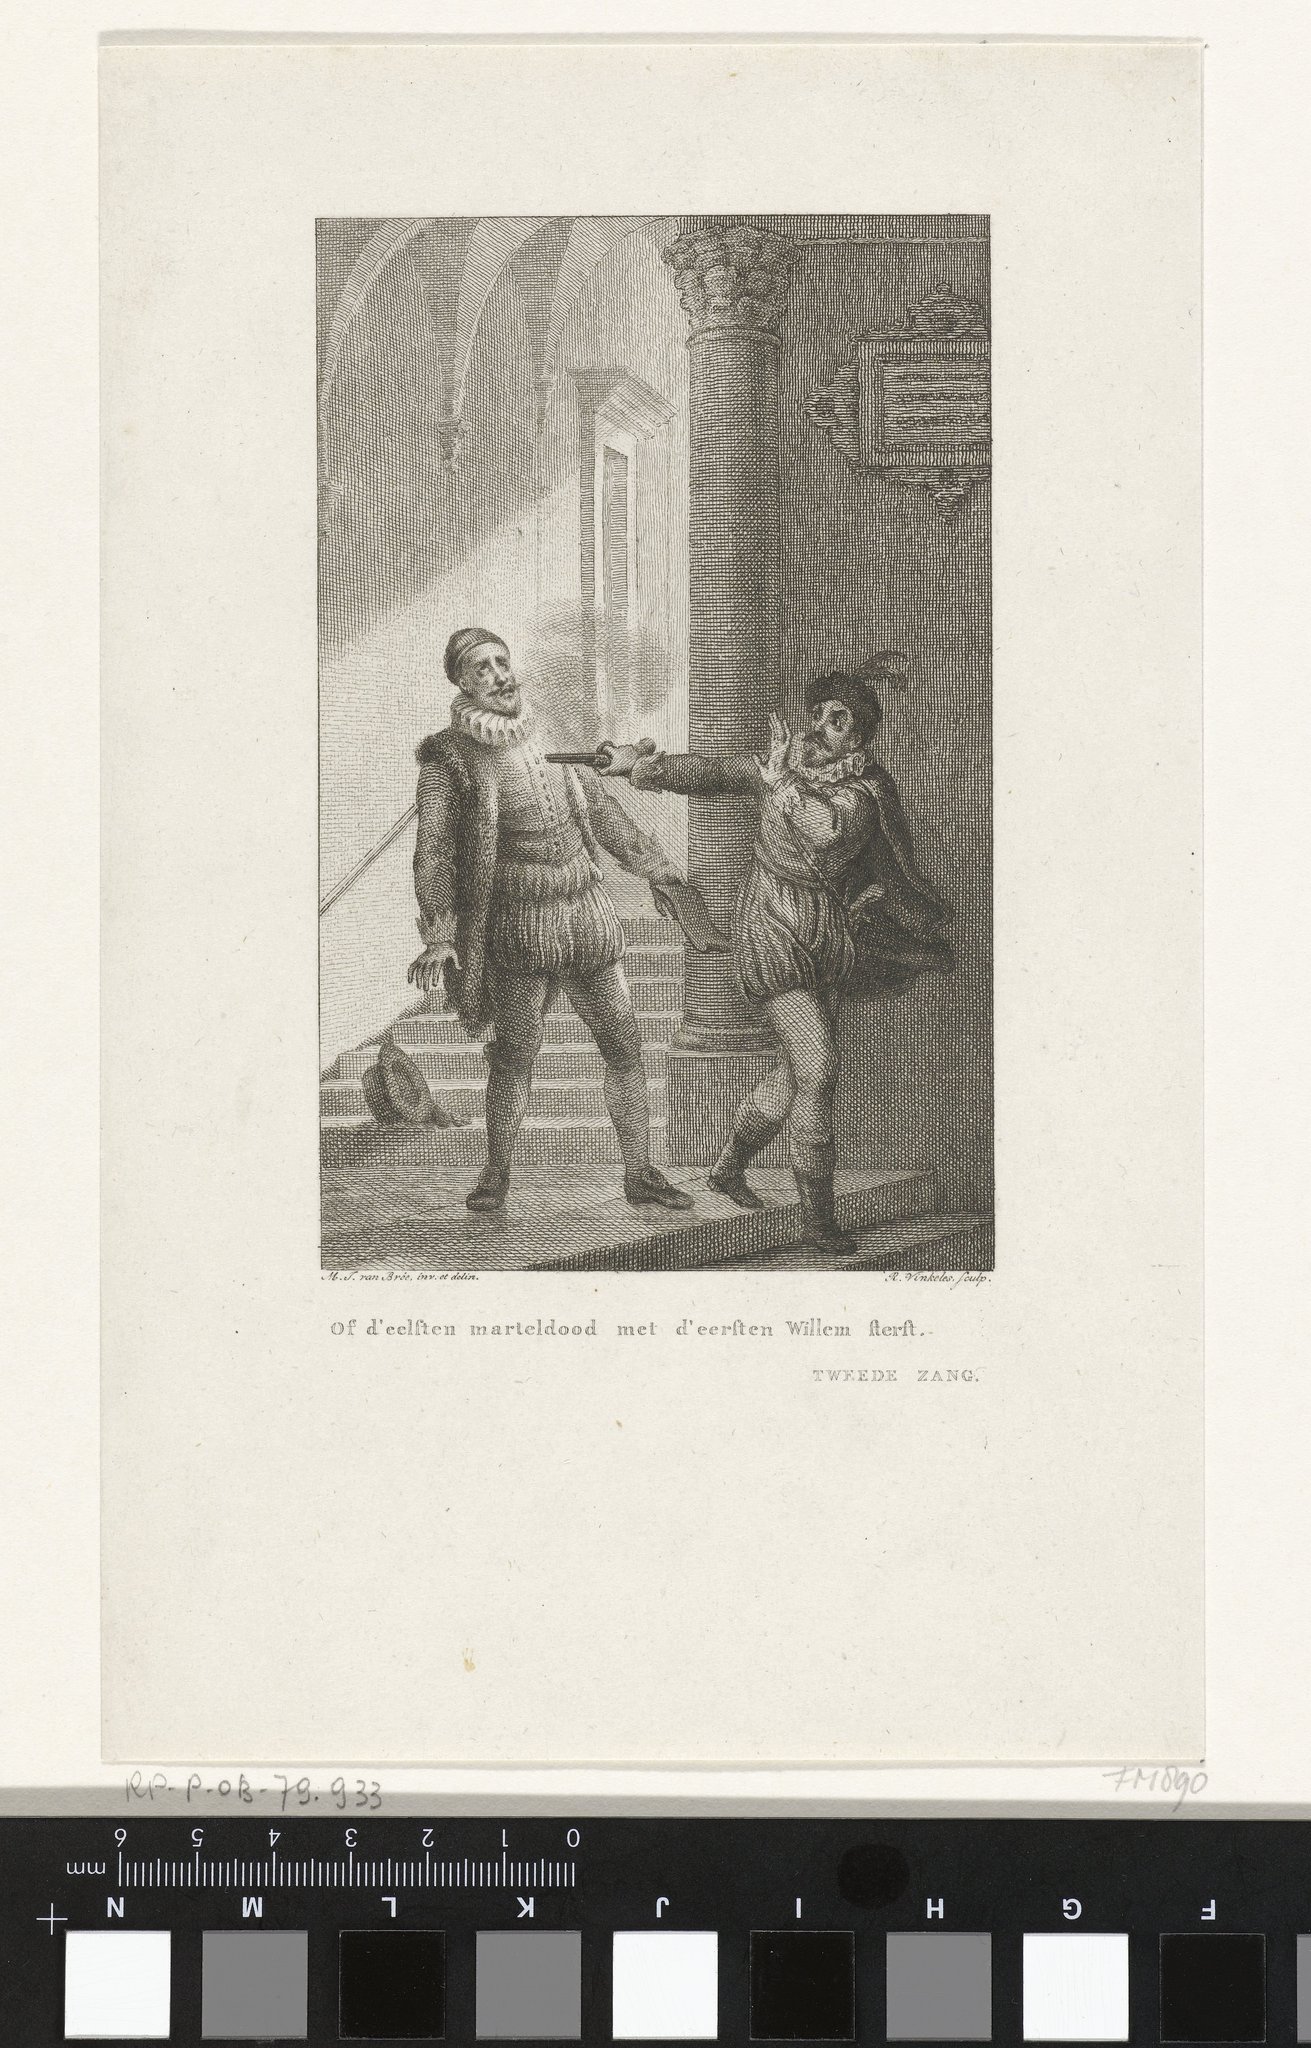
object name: print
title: Moord op Willem van Oranje, 1584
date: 1810-1812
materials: paper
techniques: etching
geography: netherlands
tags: delft, william i (prince of orange), attempt, political murder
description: De prins van Oranje te Delft vermoord door Balthasar Gerards, 10 juli 1584. Willem van Oranje wordt op een trap bij de openstaande deur neergeschoten door Balthasar Gerards. Met onderschrift van 1 regel in het Nederlands.